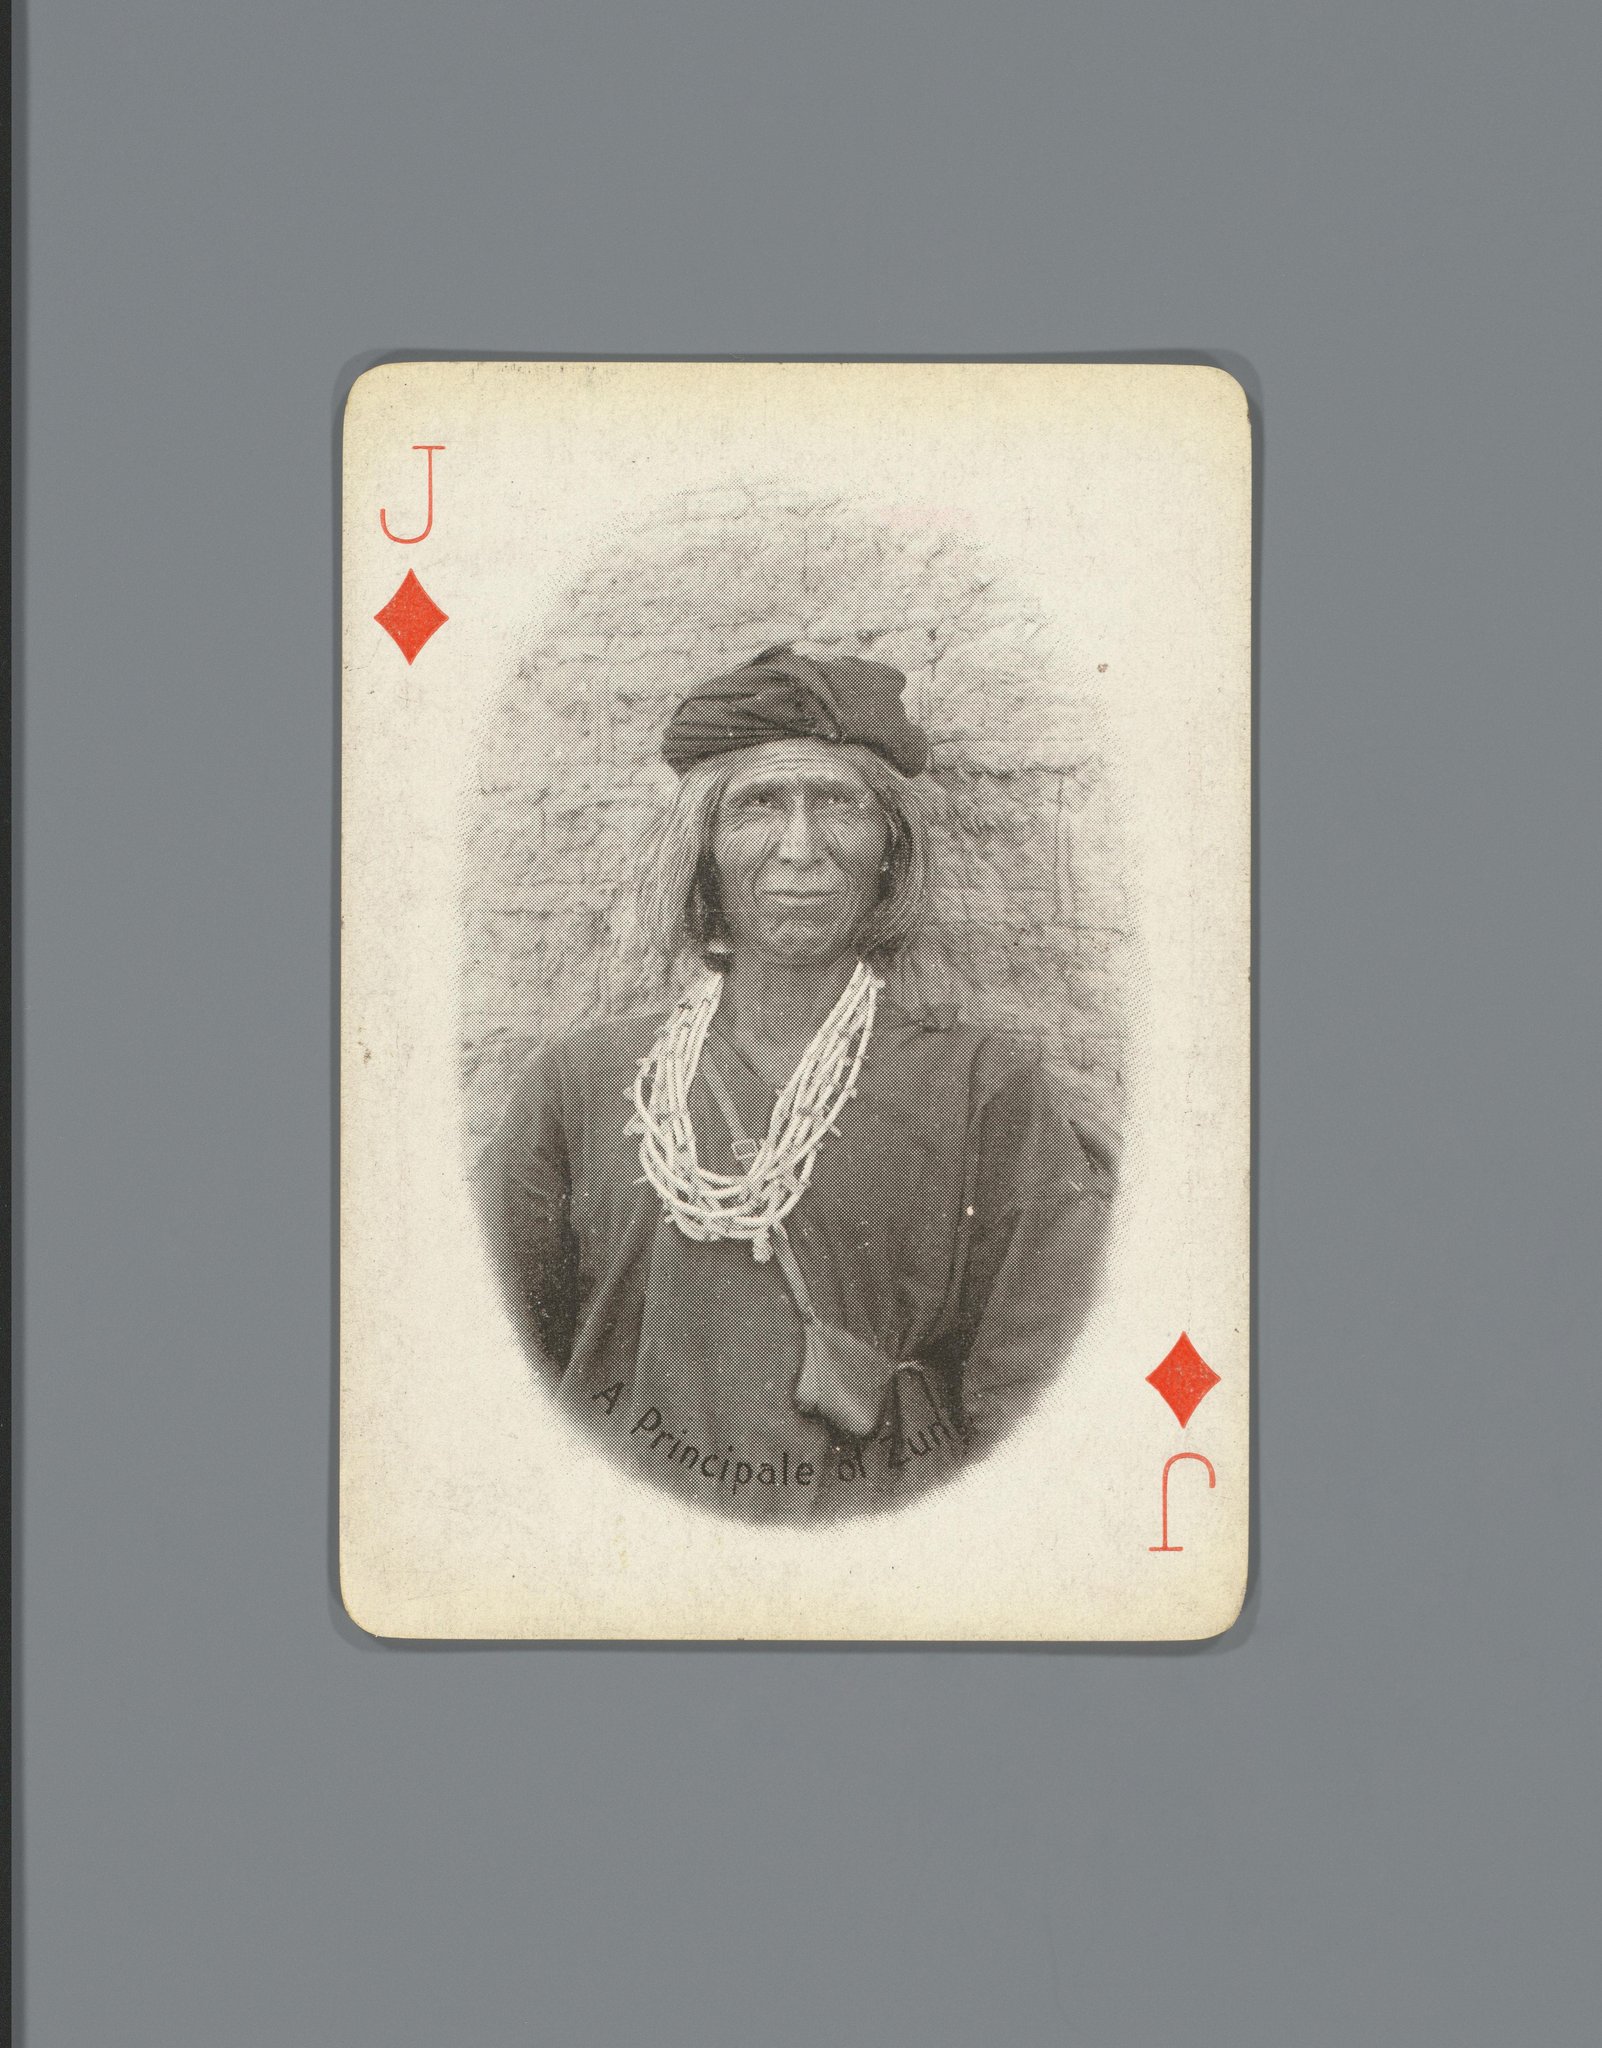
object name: playing card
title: Ruiten boer met Zunileider, New Mexico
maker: adam clark vroman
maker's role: fotograaf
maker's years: 1856-1916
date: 1900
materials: paper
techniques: autotype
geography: united states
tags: new mexico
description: Speelkaart uit doosje met 53 speelkaarten met afbeeldingen in autotypie van Native Americans. De inhoud bevat een complete set speelkaarten inclusief joker.